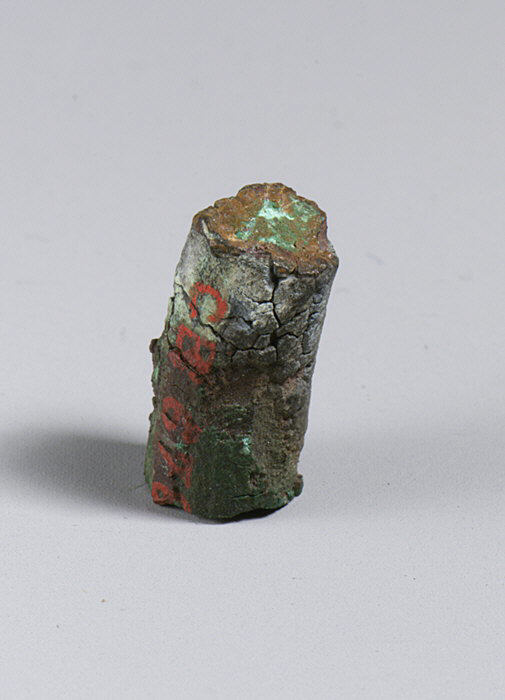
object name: bracelet, armlet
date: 7000 BCE-330 CE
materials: bronze